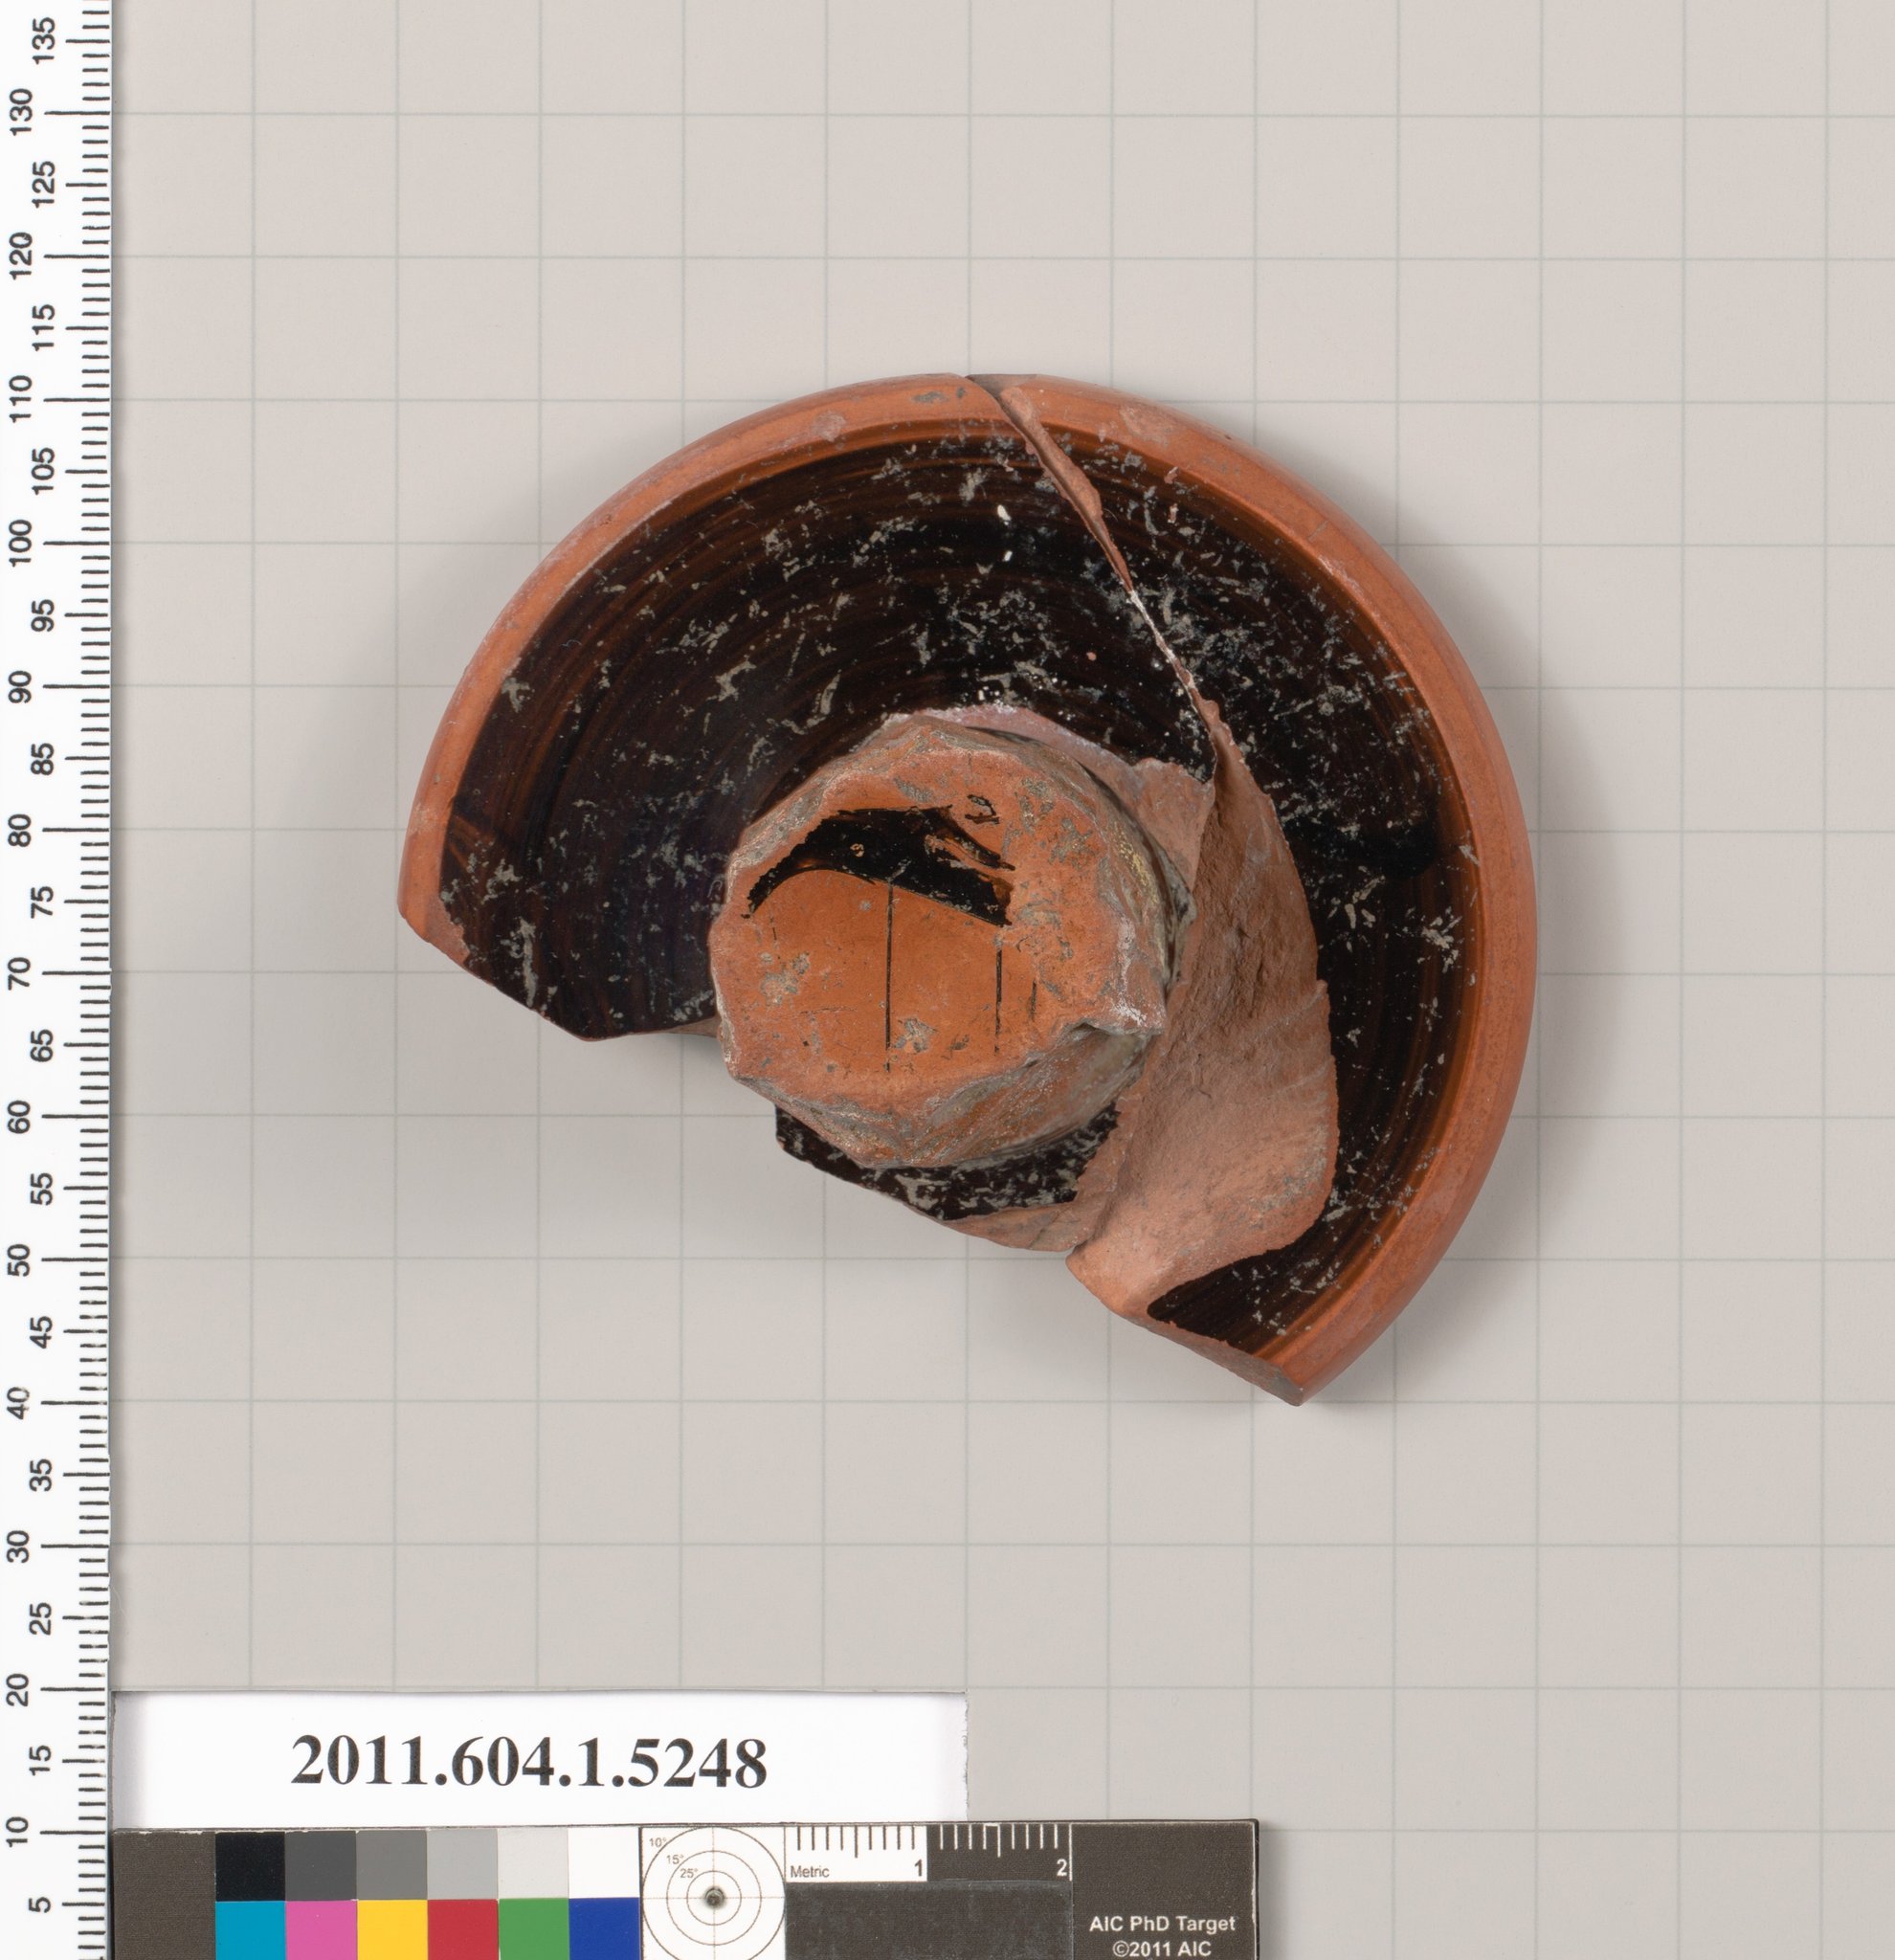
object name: kylix fragment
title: Terracotta fragment of a kylix (drinking cup)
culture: greek, attic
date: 500-480 BCE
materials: terracotta